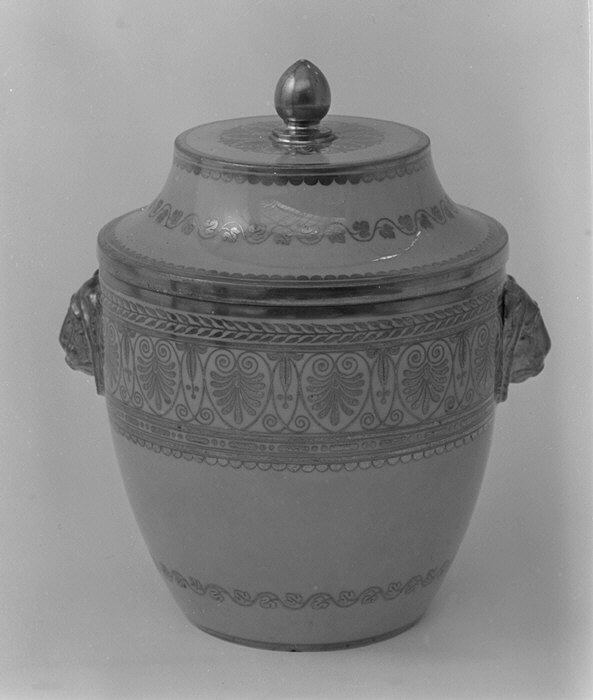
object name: sugar bowl with cover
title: Sugar bowl with cover (pot à sucre pestum) (part of a service)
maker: sèvres manufactory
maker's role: manufactory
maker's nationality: french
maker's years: 1740-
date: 1844-1846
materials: hard paste porcelain